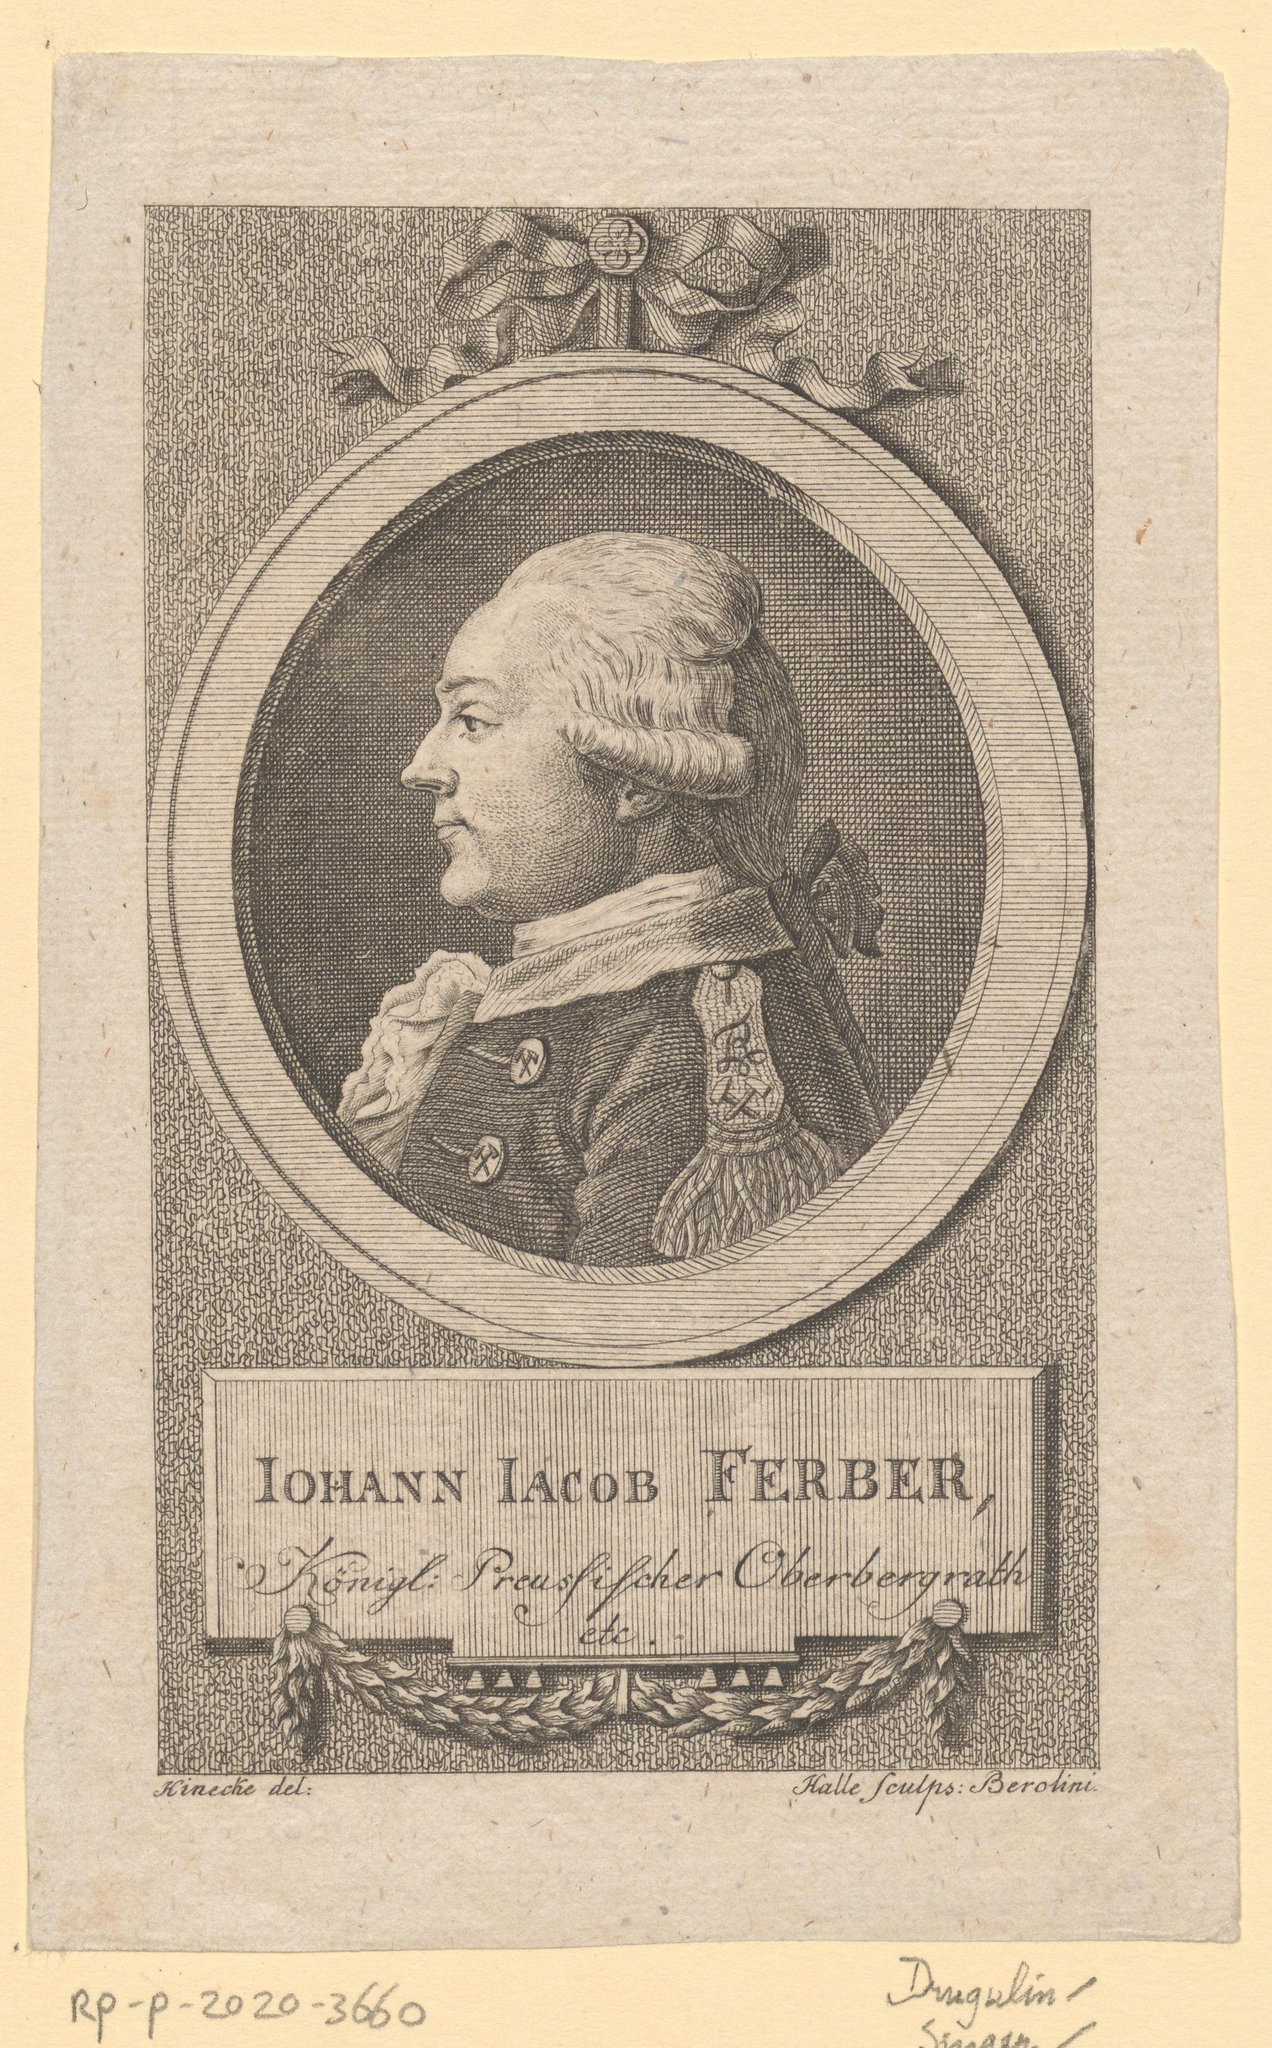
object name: print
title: Portret van Johann Jacob Ferber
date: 1753-1790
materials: paper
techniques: engraving, etching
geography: berlin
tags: ornament ~ medallion, historical persons, ornament ~ festoon, garland